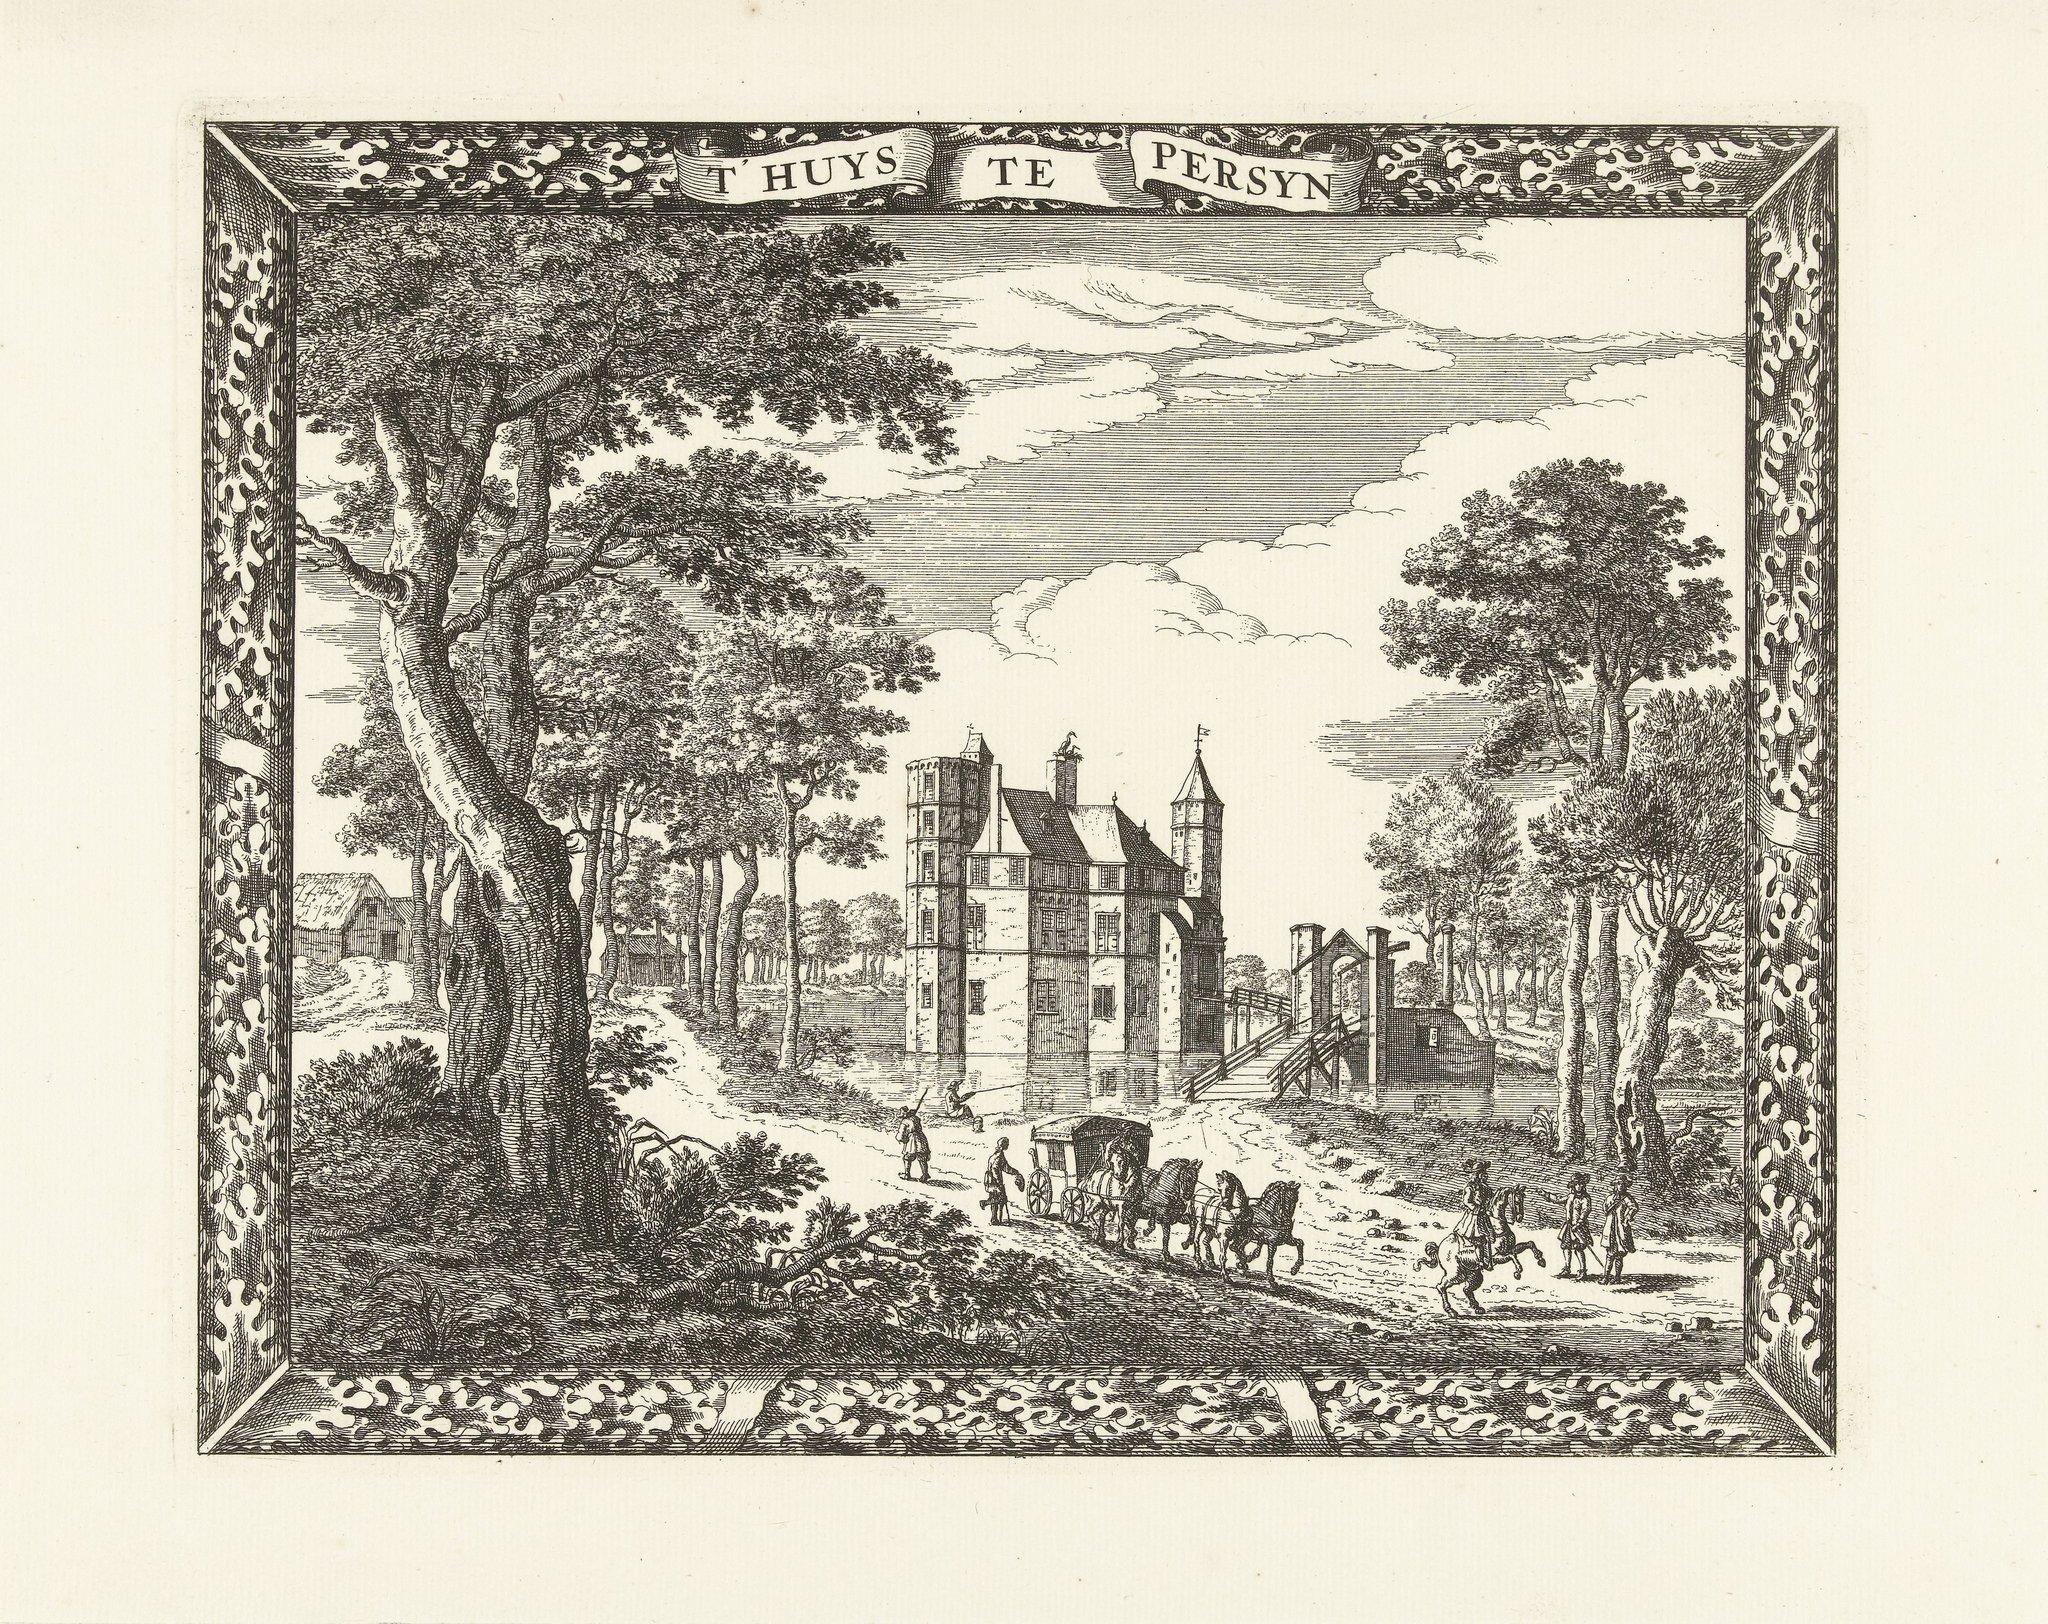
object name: print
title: T' Huys te Persyn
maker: cornelis elandts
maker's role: draughtsman, painter, print maker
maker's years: 1641-1687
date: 1681-1728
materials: paper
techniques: etching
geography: the hague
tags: castle, landscape with tower or castle, bridge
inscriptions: collector's mark: Lugt 2228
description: Deze prent is oorspronkelijk uitgegeven als onderdeel van de rand van de zogenaamde figuratieve kaart van Den Haag uit 1681-1682 (zie RP-P-AO-12-9D). De rand bestond uit een gezicht op de stad en veertien kleinere gezichten in en om Den Haag. Veertien van de vijftien prenten van de rand zijn later ook gebruikt in: Aa, Pieter van der. La galerie agreable du monde (...). 66 delen. Leiden: Pieter van der Aa, 1728, dl. 18 en 19. De huidige prent komt voor in dl. 18. Voor de overige prenten van de rand, zie: RP-P-AO-12-8, RP-P-AO-12-8-2, RP-P-OB-50.201, RP-P-OB-50.202, RP-P-OB-50.203, RP-P-OB-50.204, RP-P-OB-50.205, RP-P-OB-50.206, RP-P-OB-50.207, RP-P-OB-102.387, RP-P-OB-50.209, RP-P-OB-50.210, RP-P-OB-50.211, RP-P-OB-50.212, RP-P-OB-50.213, RP-P-AO-12-5-4 en RP-P-OB-50.214.